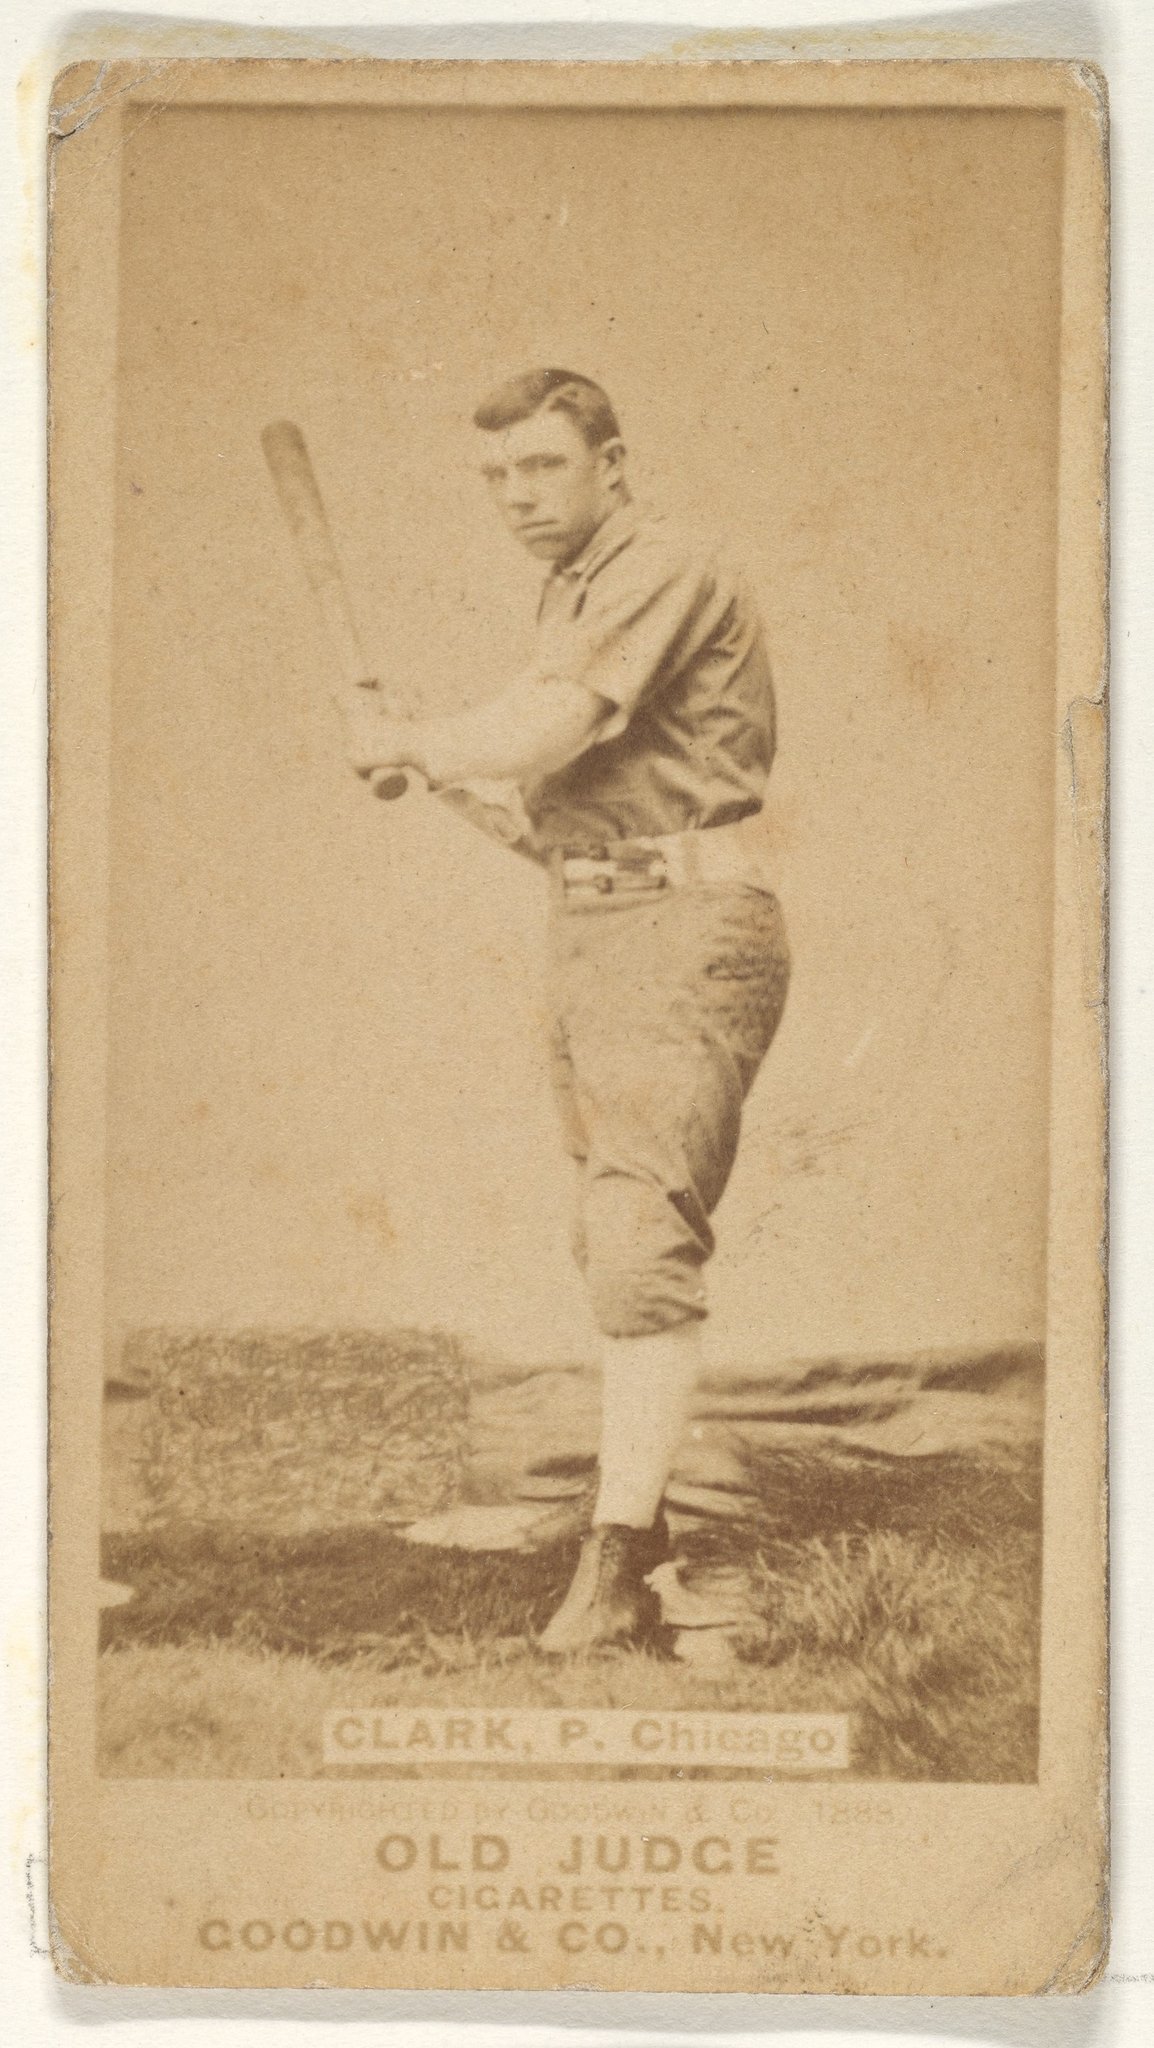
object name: baseball card, photograph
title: William H. "Dad" Clarke, Pitcher, Chicago, from the Old Judge series (N172) for Old Judge Cigarettes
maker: goodwin & company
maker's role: publisher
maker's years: 1850-1950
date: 1888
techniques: albumen silver print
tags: men,portraits,baseball,athletes